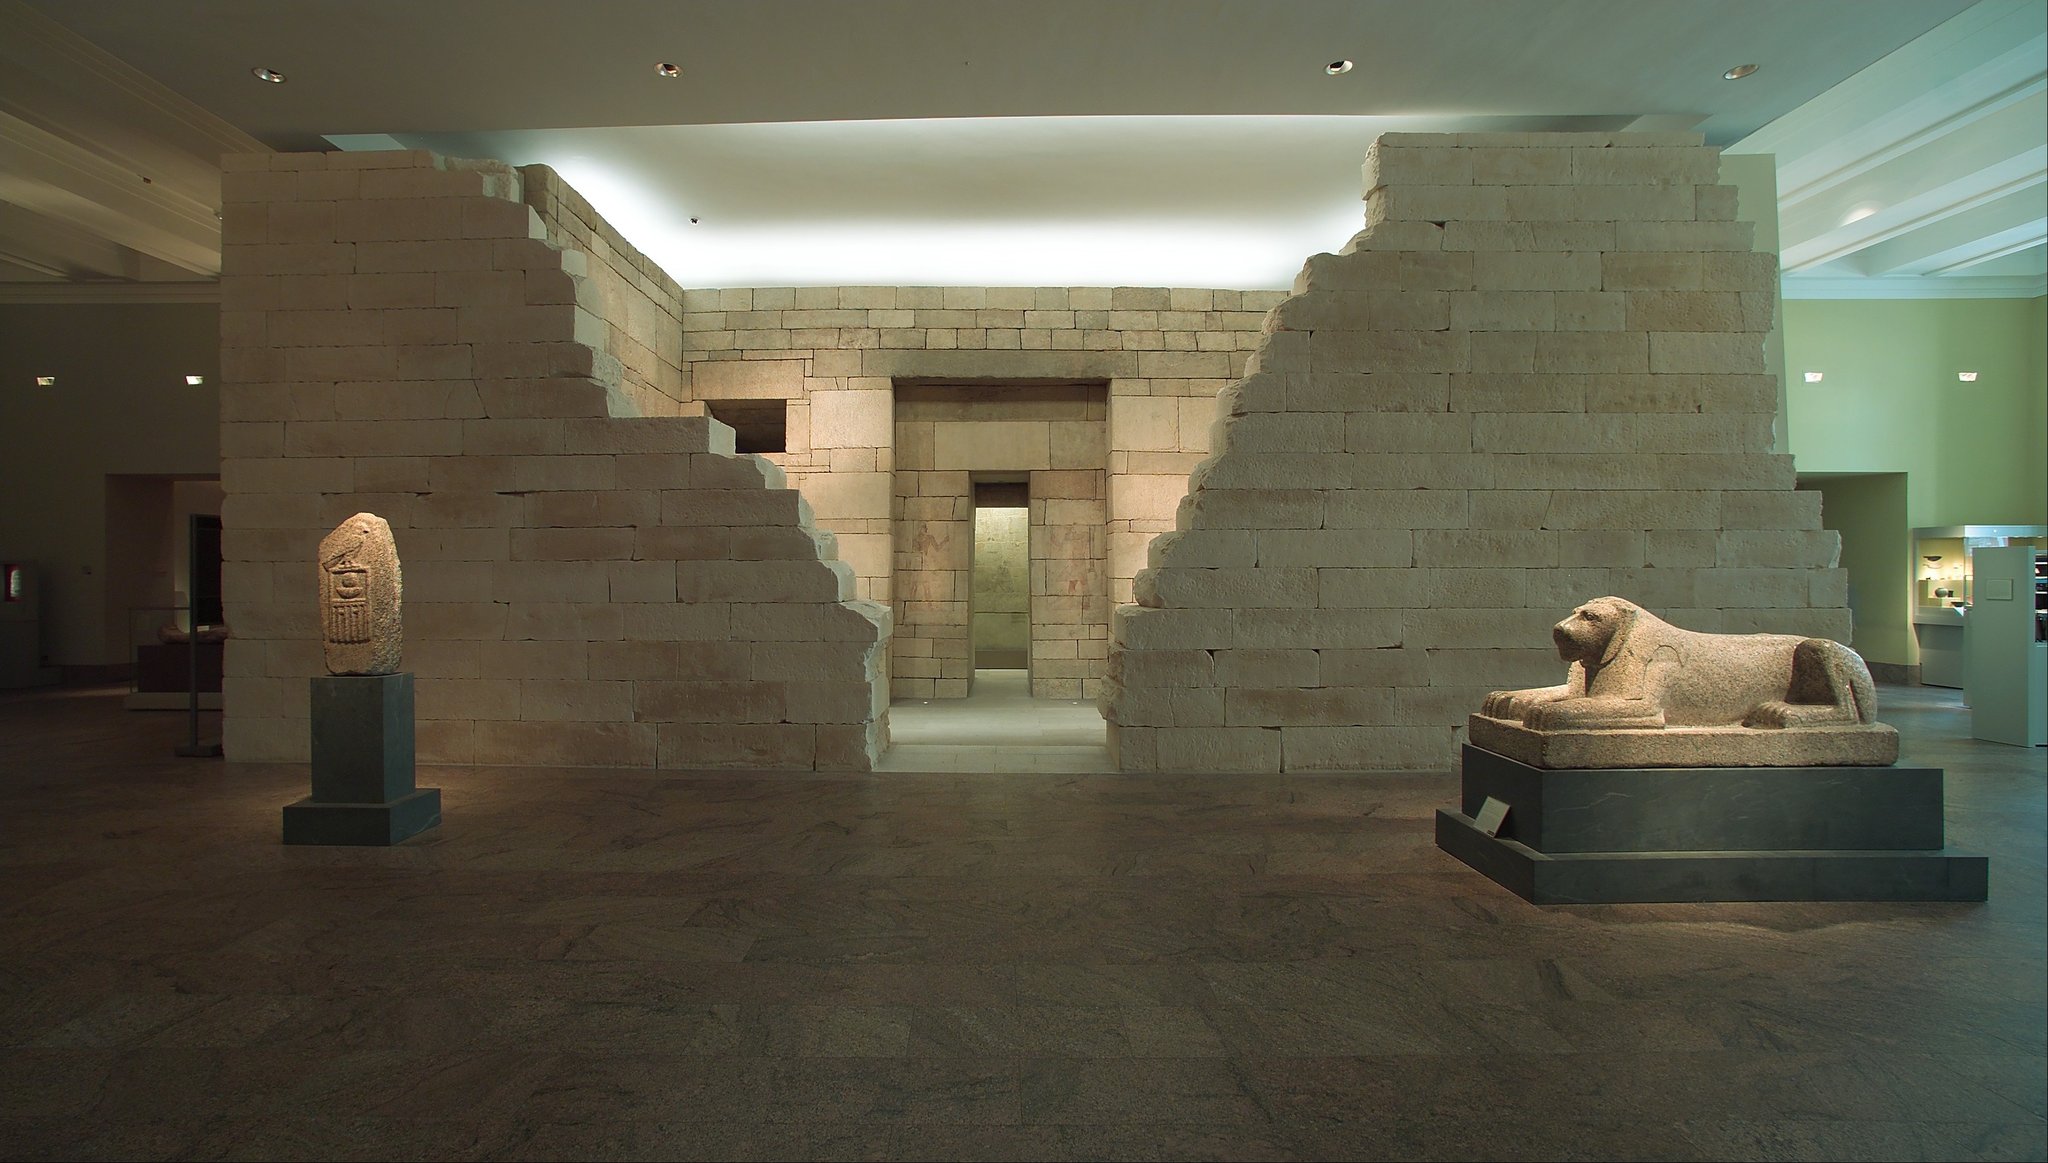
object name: mastaba, perneb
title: Mastaba Tomb of Perneb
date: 2381-2323 BCE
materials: limestone, paint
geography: egypt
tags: tombs